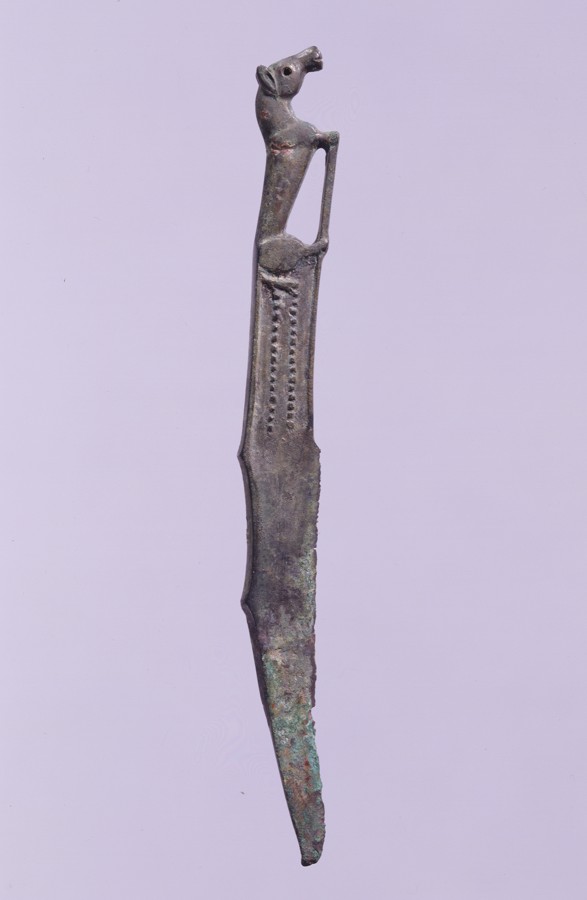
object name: knife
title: Knife with Recumbent Horse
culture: north chinese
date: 500-401 BCE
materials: bronze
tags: horses